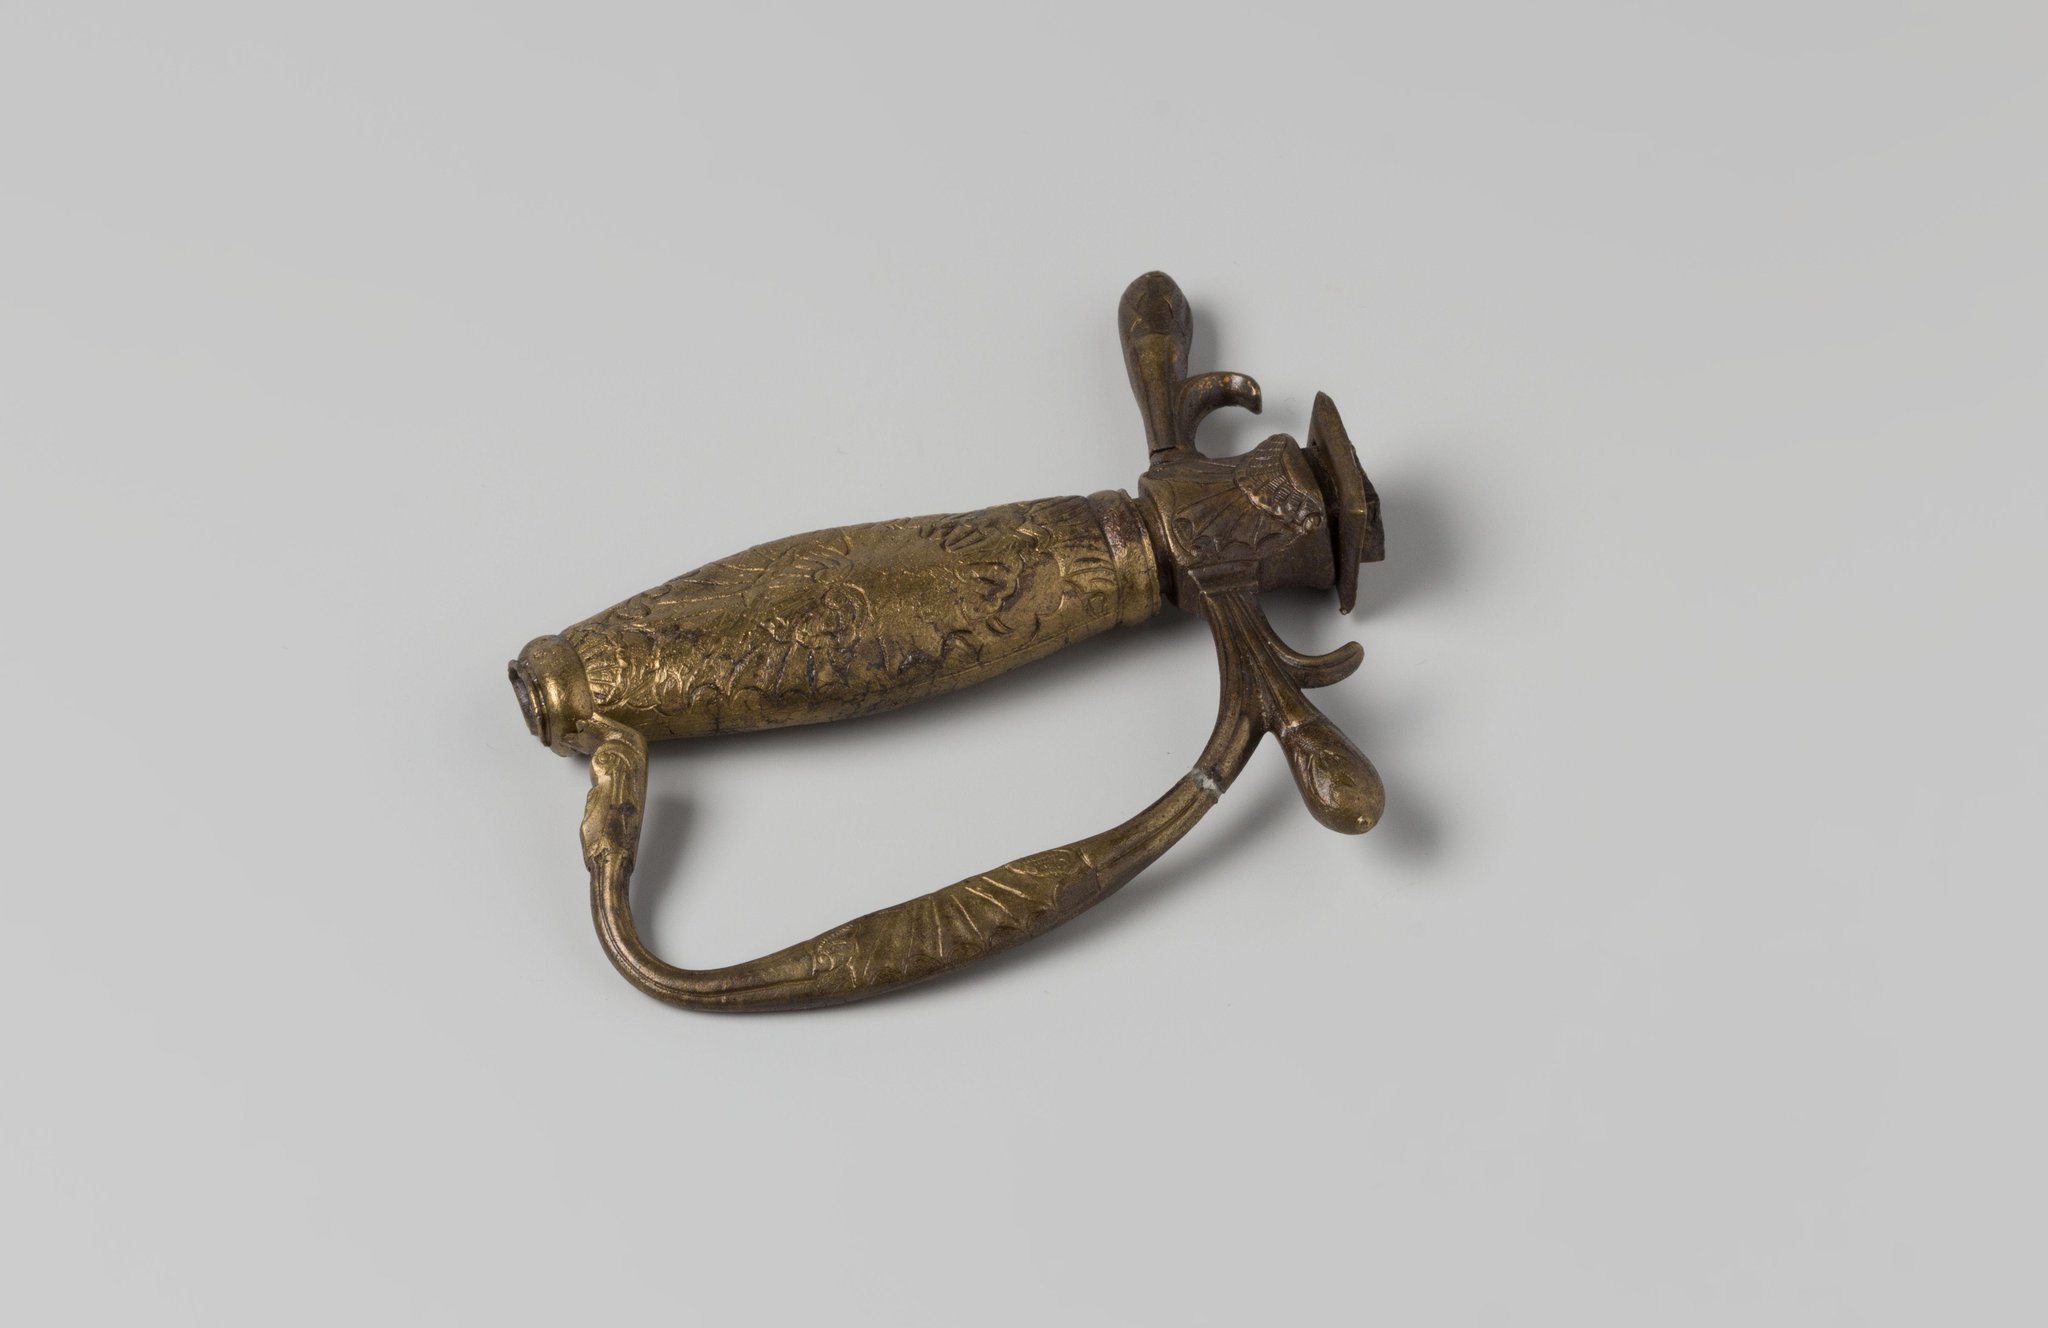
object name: greep gevest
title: Greep van een gevest uit het wrak van de Oost-Indiëvaarder Hollandia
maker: Anonymous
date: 1700-1743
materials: copper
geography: netherlands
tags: verenigde oostindische compagnie, hollandia (schip), annet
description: Hilt, guard; fragm, guard-cross with double vestigial arms (pas d'ane), 2 straight quillons, knuckle-guard broken off (knuckle-guard NG 1980-27H588), quillon-block decorated with shell motif, rectangular front with (ricasso) washer, other end with oval rim, ass. grip NG 1979-173H542.